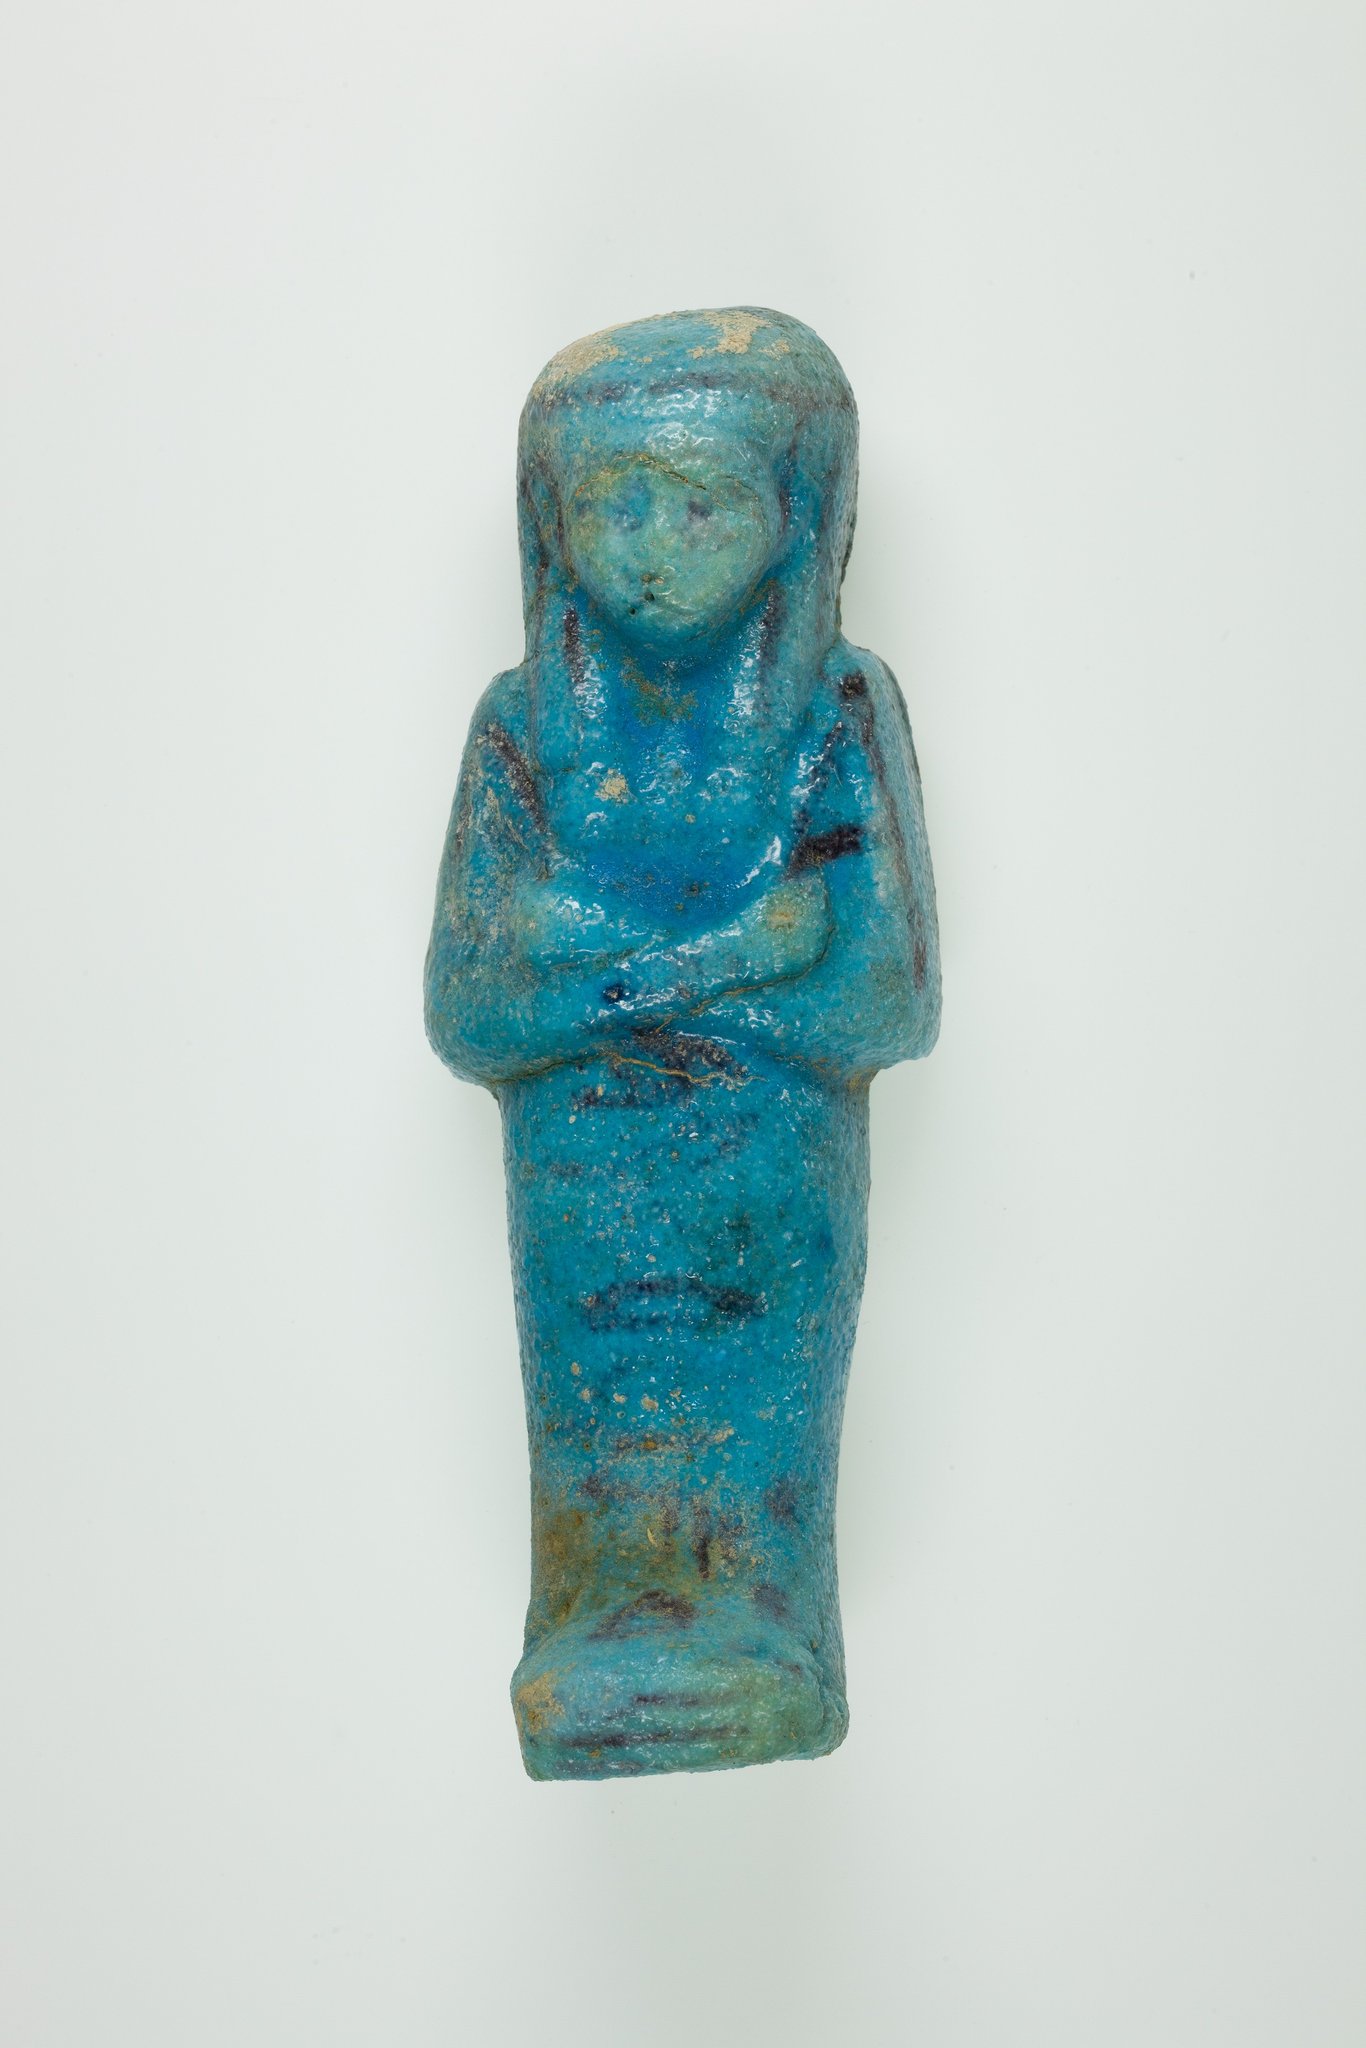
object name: worker shabti, henettawy c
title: Worker Shabti of Henettawy (C), Daughter of Isetemkheb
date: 990-970 BCE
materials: faience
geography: egypt